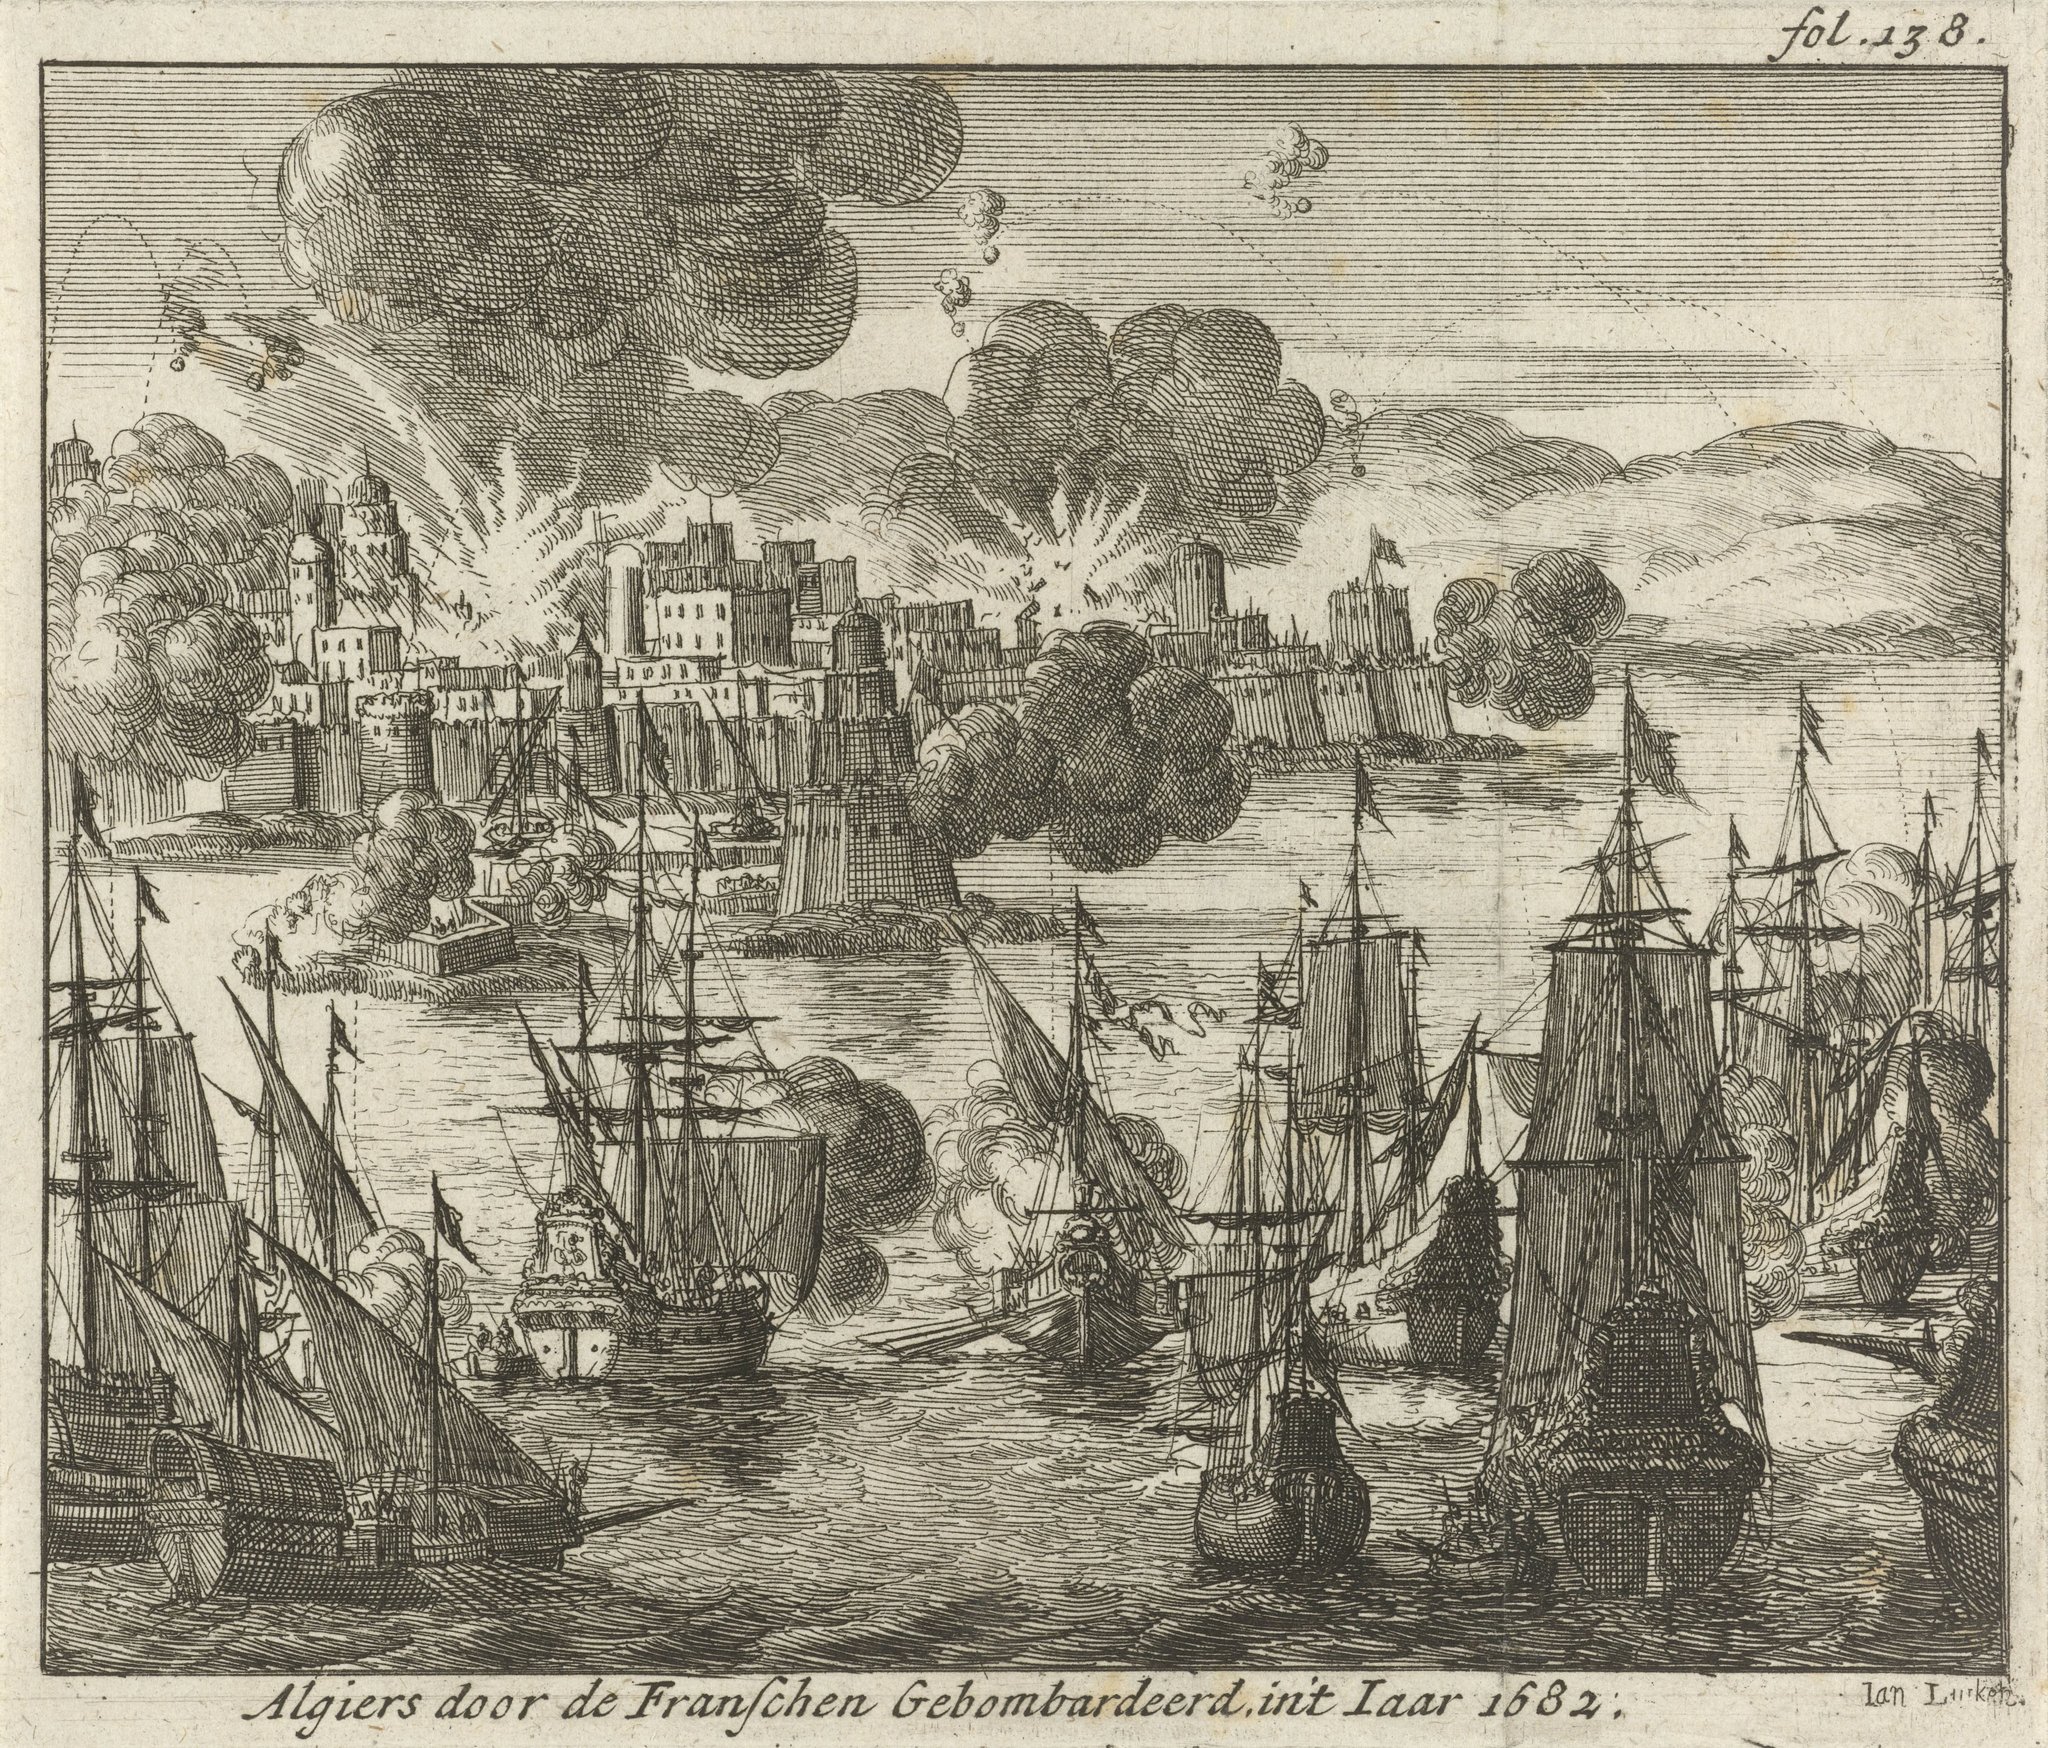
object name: print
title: Algiers door de Fransen gebombardeerd, 1682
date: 1689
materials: paper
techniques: etching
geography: amsterdam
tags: attack ~ siege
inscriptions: collector's mark: Lugt 2228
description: Illustratie uit: Pers, Dirck Pietersz. Romeynschen adelaer, waer in de loffelĳcke en lasterlĳcke daden der Romeynsche koningen, en keyseren, verhandelt werden, 3 delen. Utrecht: Jurriaen van Poolsum, 1689, fol. 138.